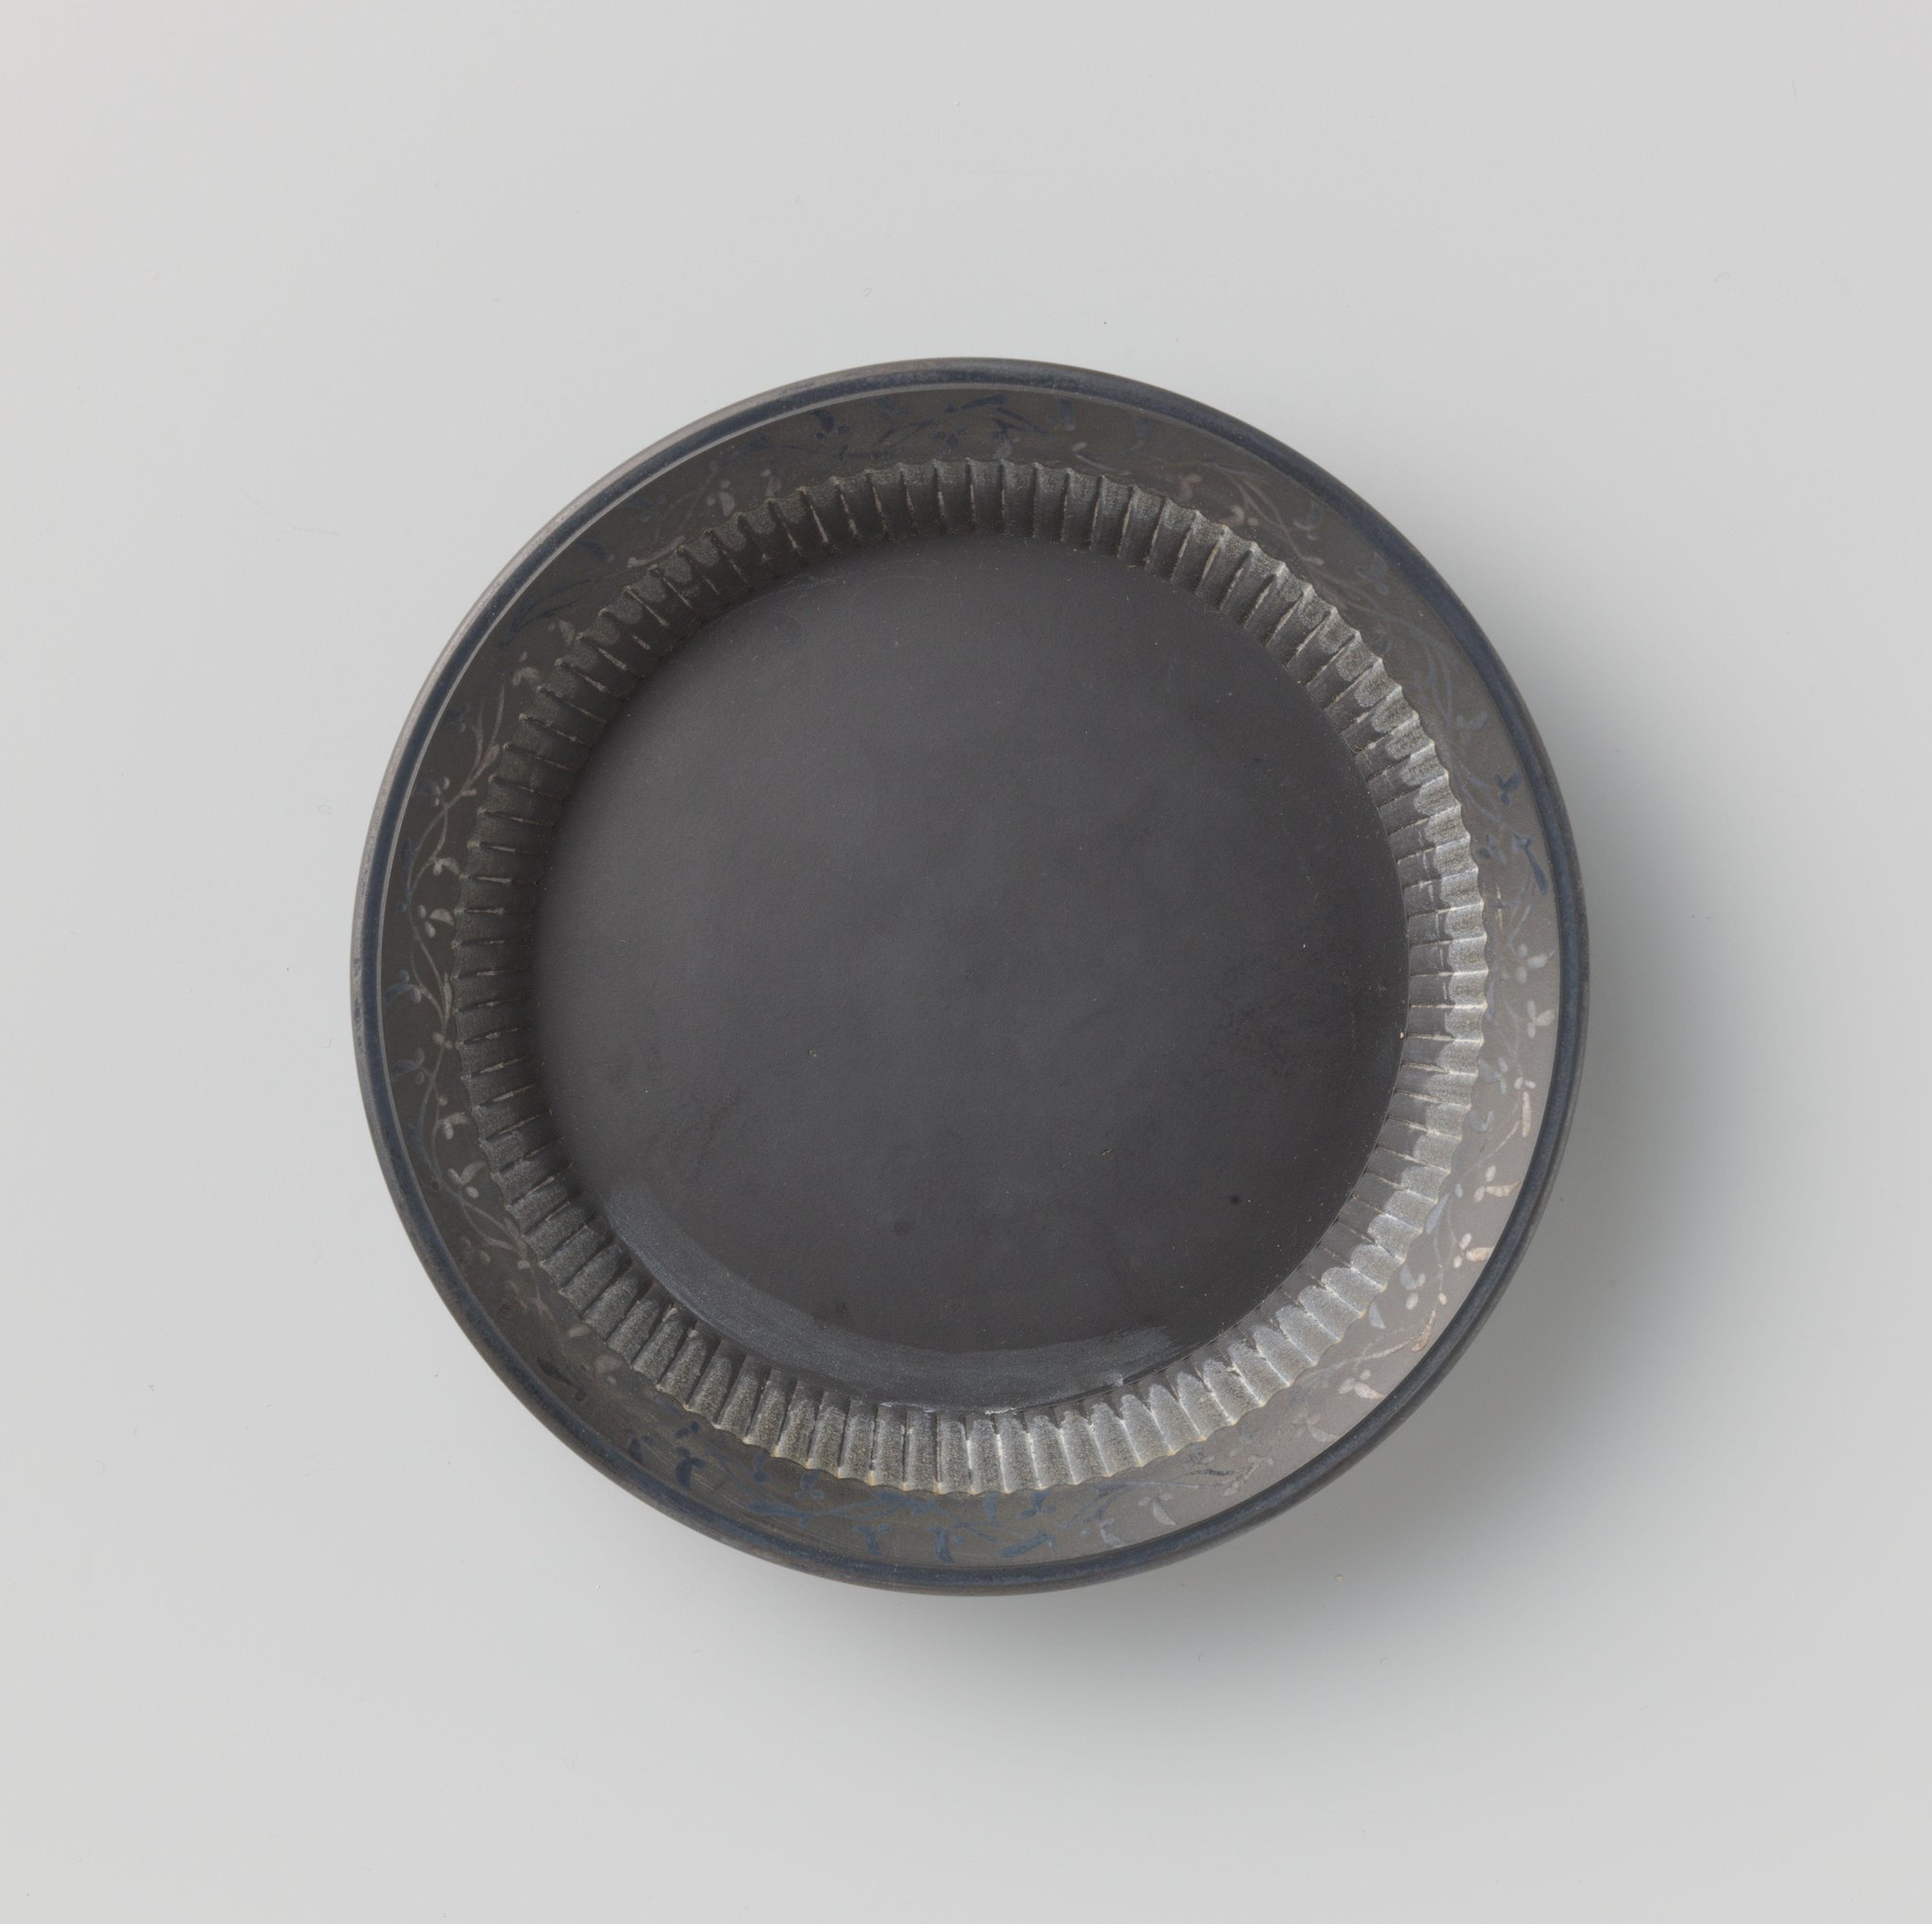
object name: dish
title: Schaal van aardewerk, Neale & Palmer Black Basalt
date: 1790-1825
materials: earthenware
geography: hanley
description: Ronde schaal van aardewerk, Black Basalt. De rand van de schaal is langs de binnenrand geribd en heeft langs de buitenrand een zilverkleurige bladrank.